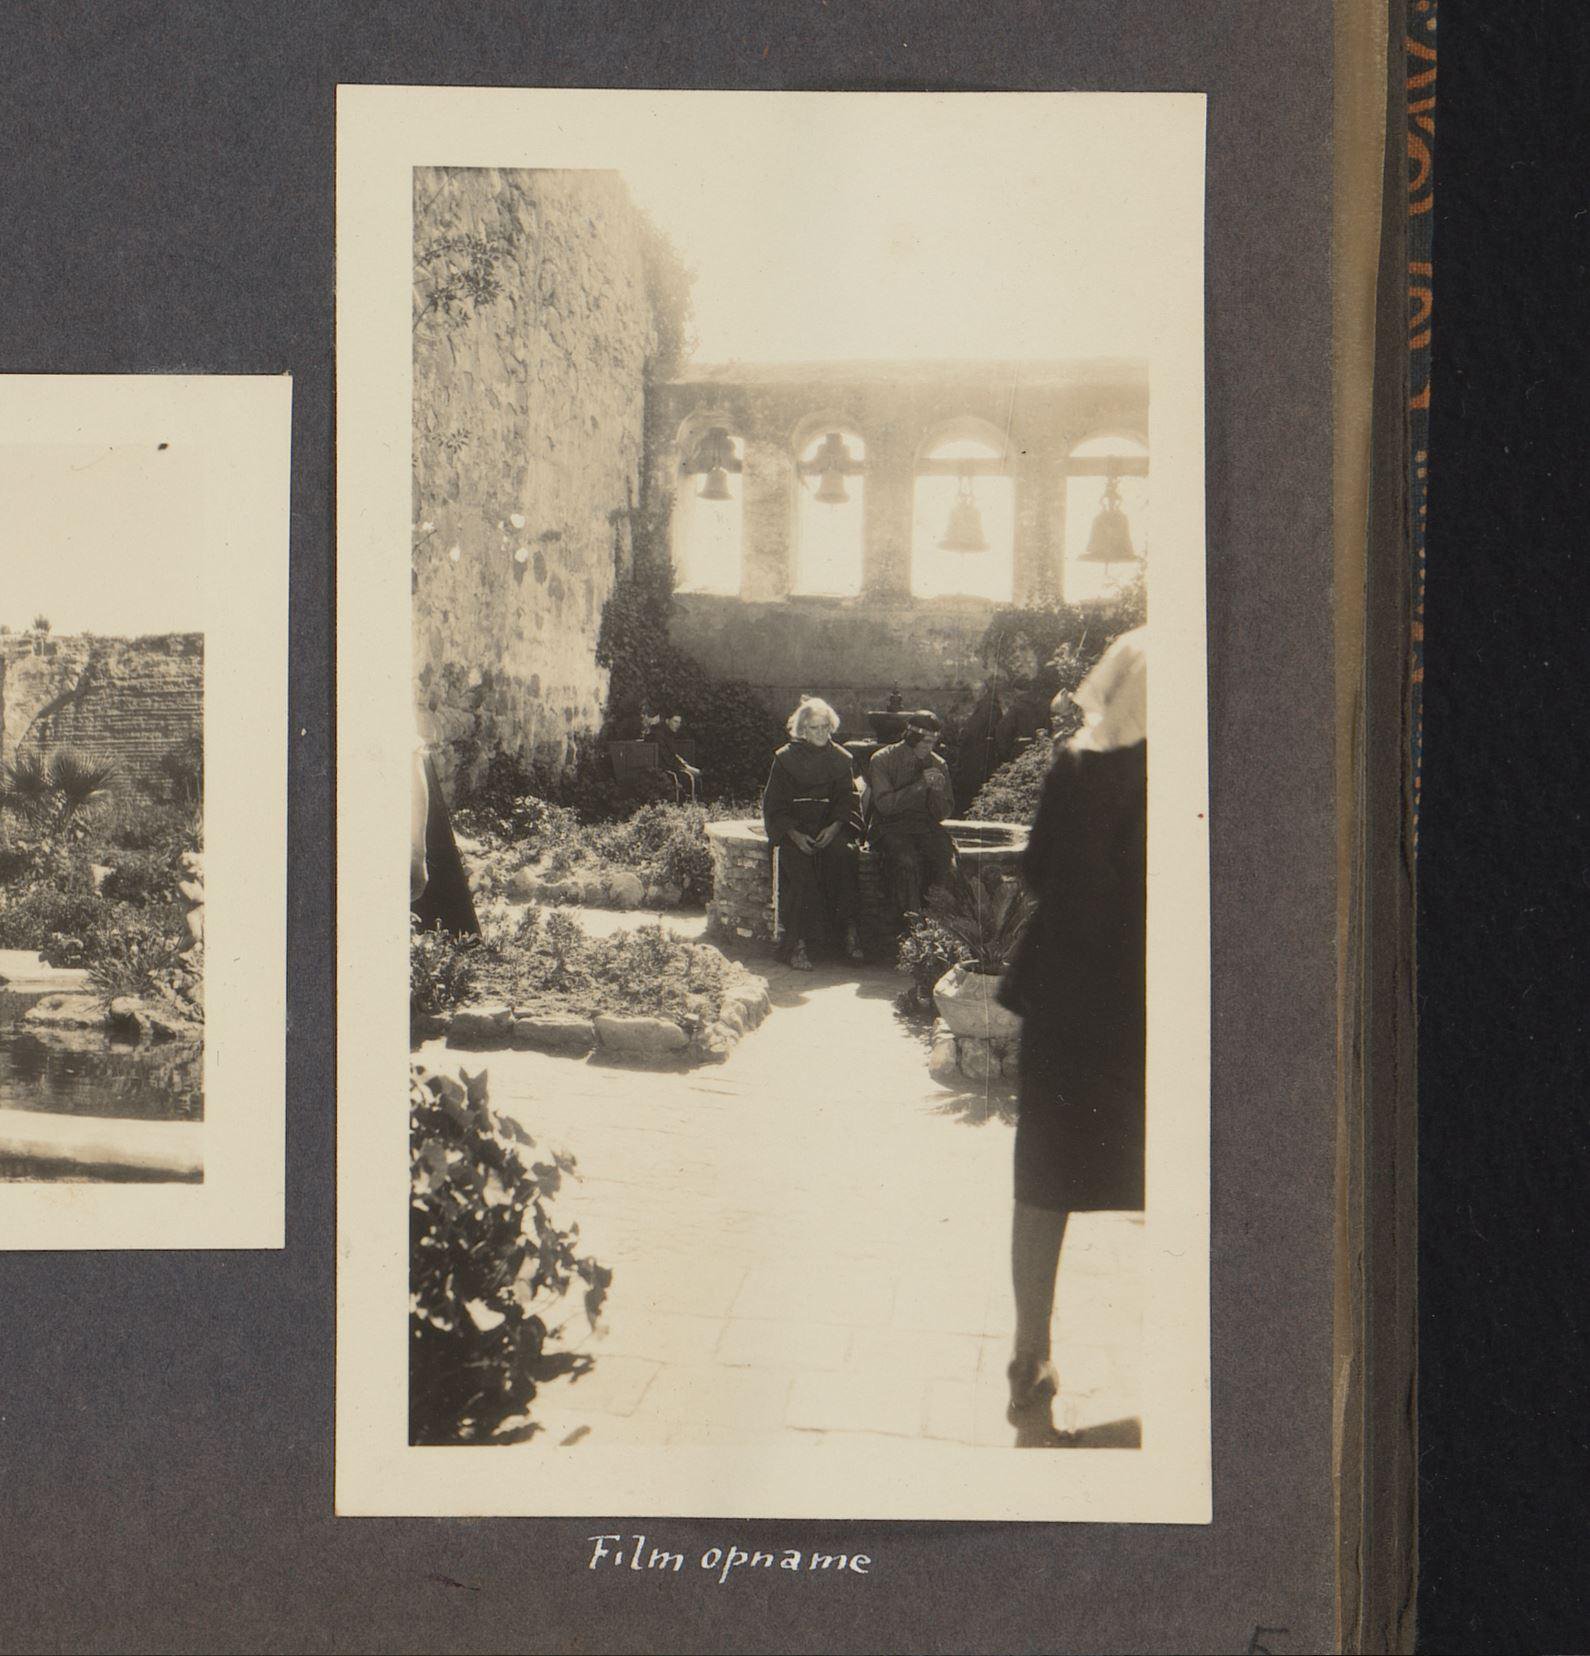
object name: photograph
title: Drie personen op vermoedelijk de binnenplaats van Mission San Juan Capistrano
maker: Anonymous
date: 1928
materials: photographic support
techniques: gelatin silver print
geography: san juan capistrano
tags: historical persons, courtyard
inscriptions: annotation: ‘Film opname’, annotation: ‘San Juan Capistrano’